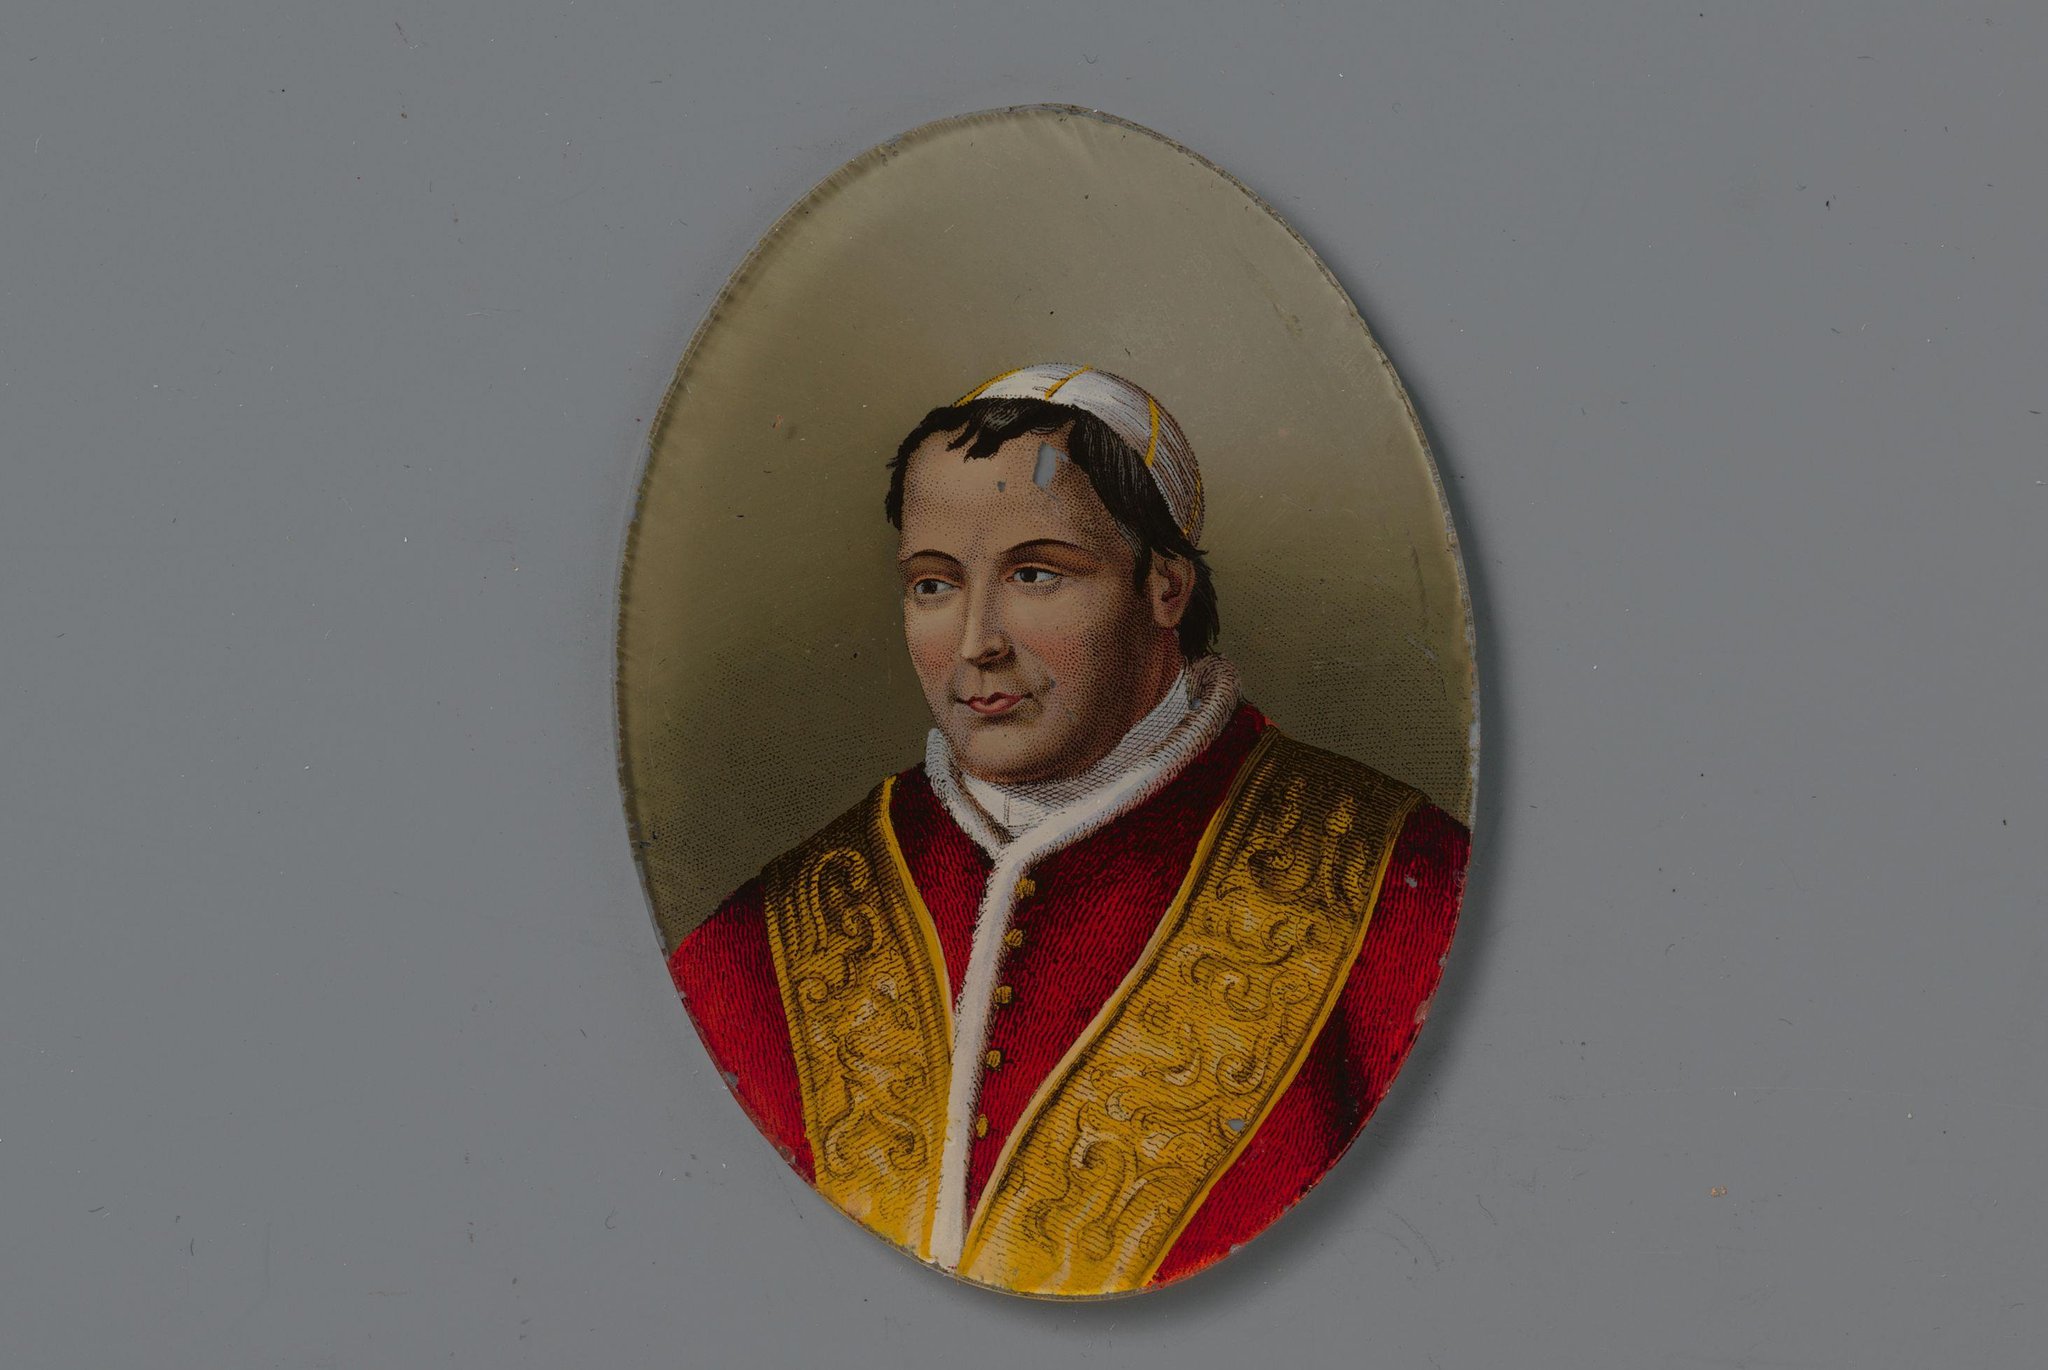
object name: photograph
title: Portret van een onbekende bisschop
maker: Anonymous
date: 1850-1900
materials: glass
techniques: photography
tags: archbishop, bishop, etc. (roman catholic), historical persons